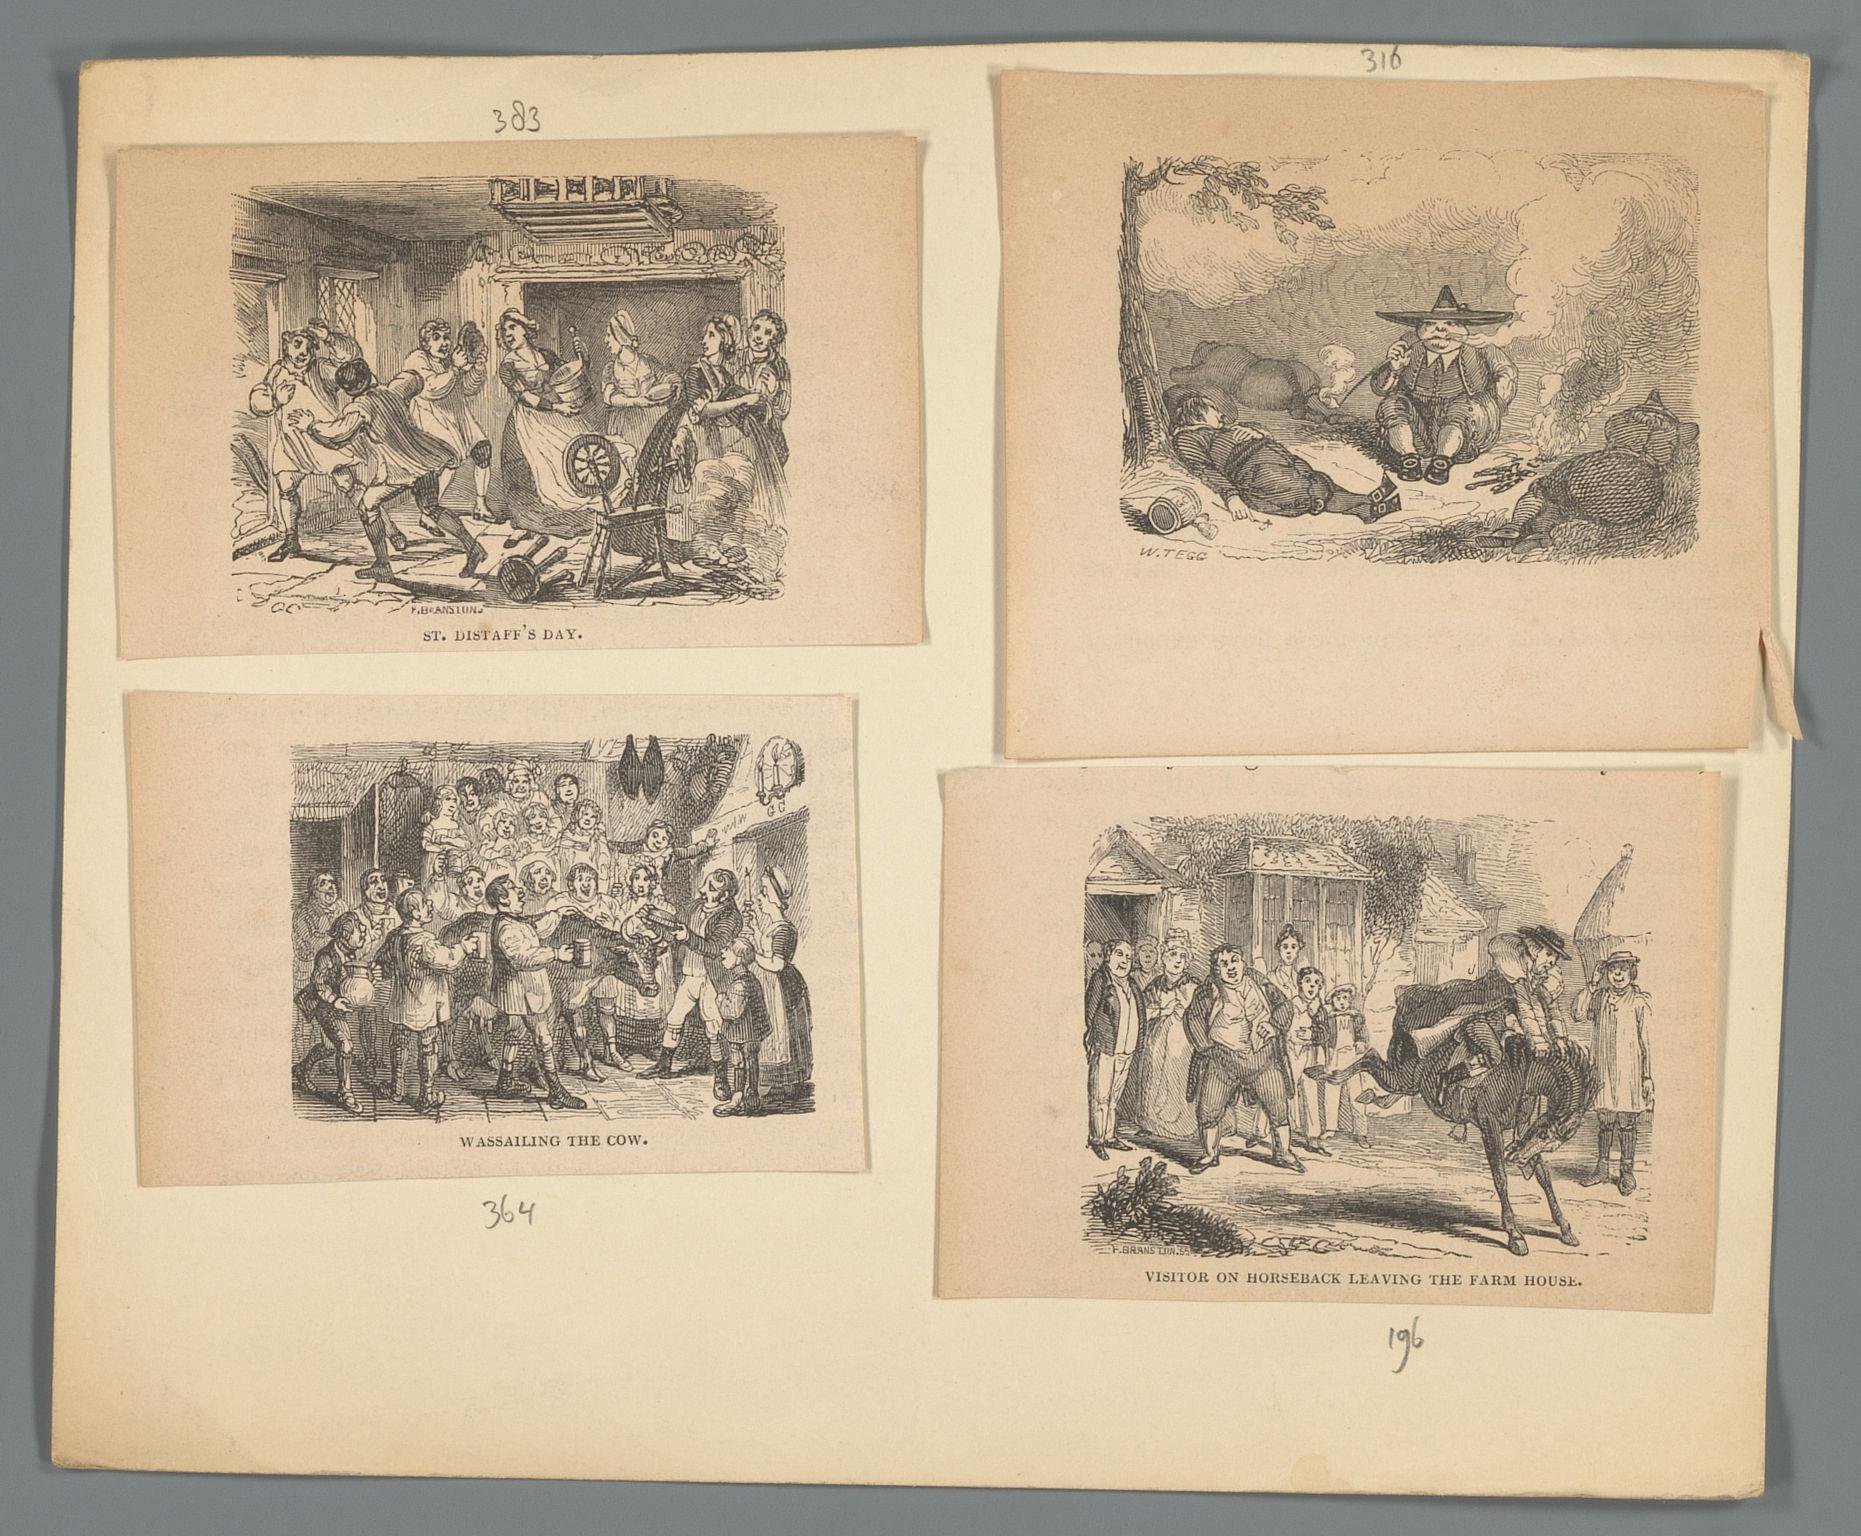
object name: book illustration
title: Vier illustraties uit: Peter Parley’s Tales About Christmas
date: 1836-1838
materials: paper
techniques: engraving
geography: england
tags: christmas (non-liturgical celebration), political caricatures and satires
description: Vier boekillustraties geknipt uit een uitgave van Peter Parley’s Tales About Christmas (1838), p. 196, 316, 364 en 383. Opgeplakt op een stuk papier.